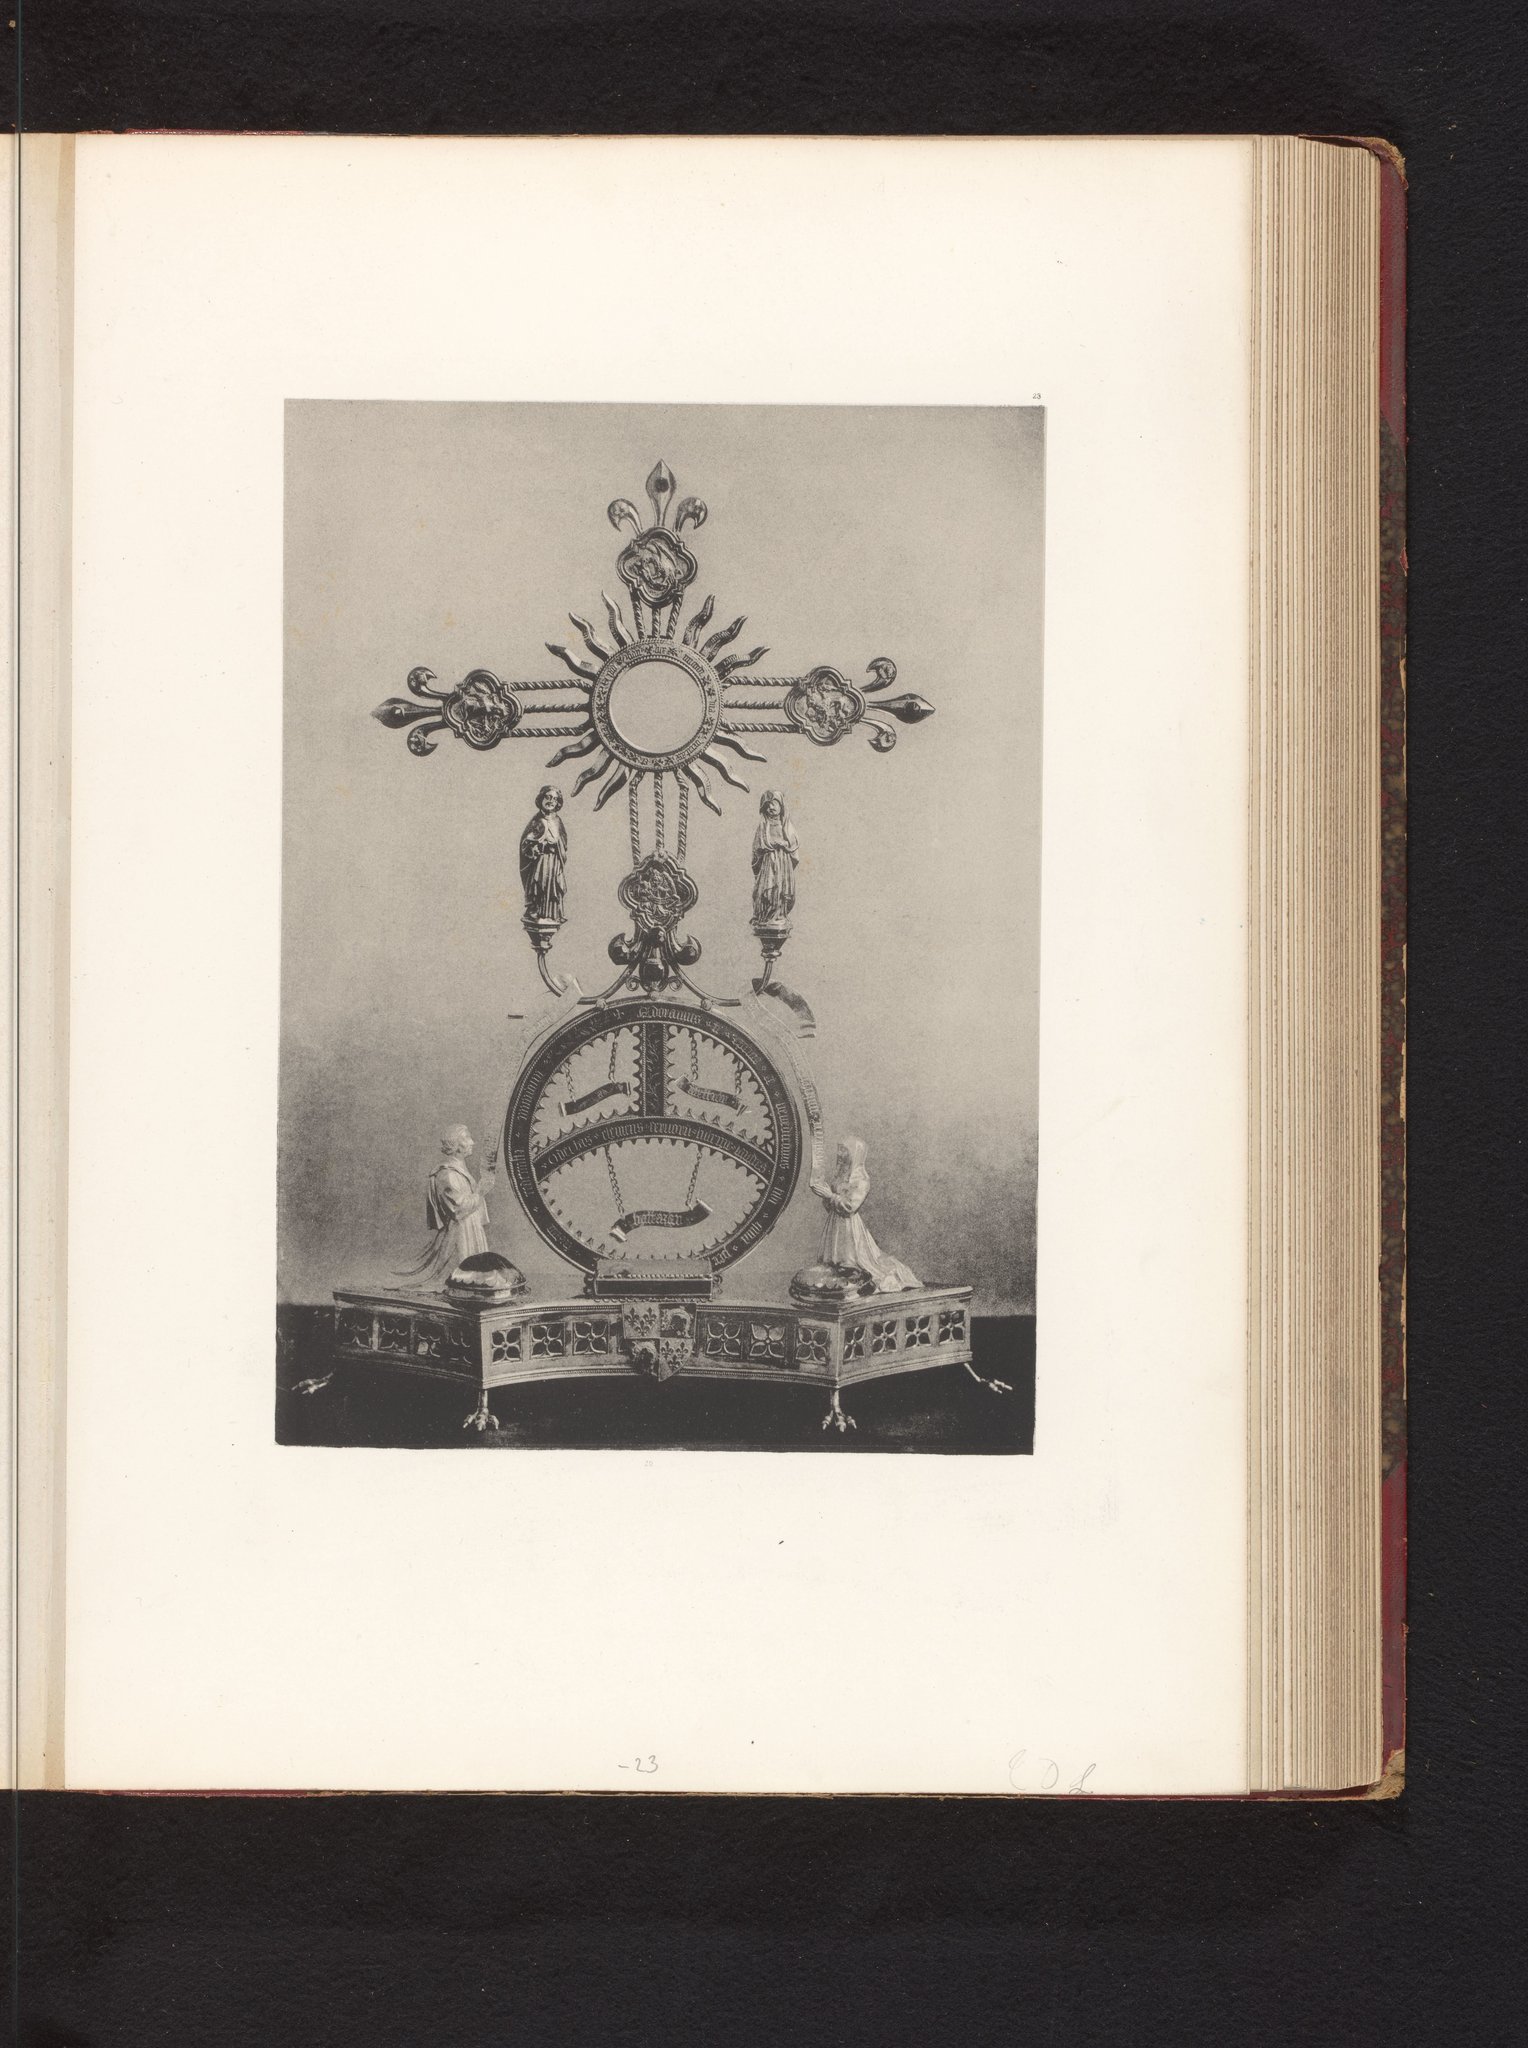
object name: photomechanical print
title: Monstrans uit de Sint-Martinusbasiliek in Halle, opgesteld op een tentoonstelling over religieuze objecten uit de middeleeuwen en renaissance in 1864 in Mechelen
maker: joseph maes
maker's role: fotograaf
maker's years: 1838-1908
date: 1864-1866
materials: paper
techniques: photolithography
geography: antwerp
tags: ostensorium, monstrance, relics (and reliquaries), mechelen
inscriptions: number: ‘20’, number: ‘20’, number: ‘-23’